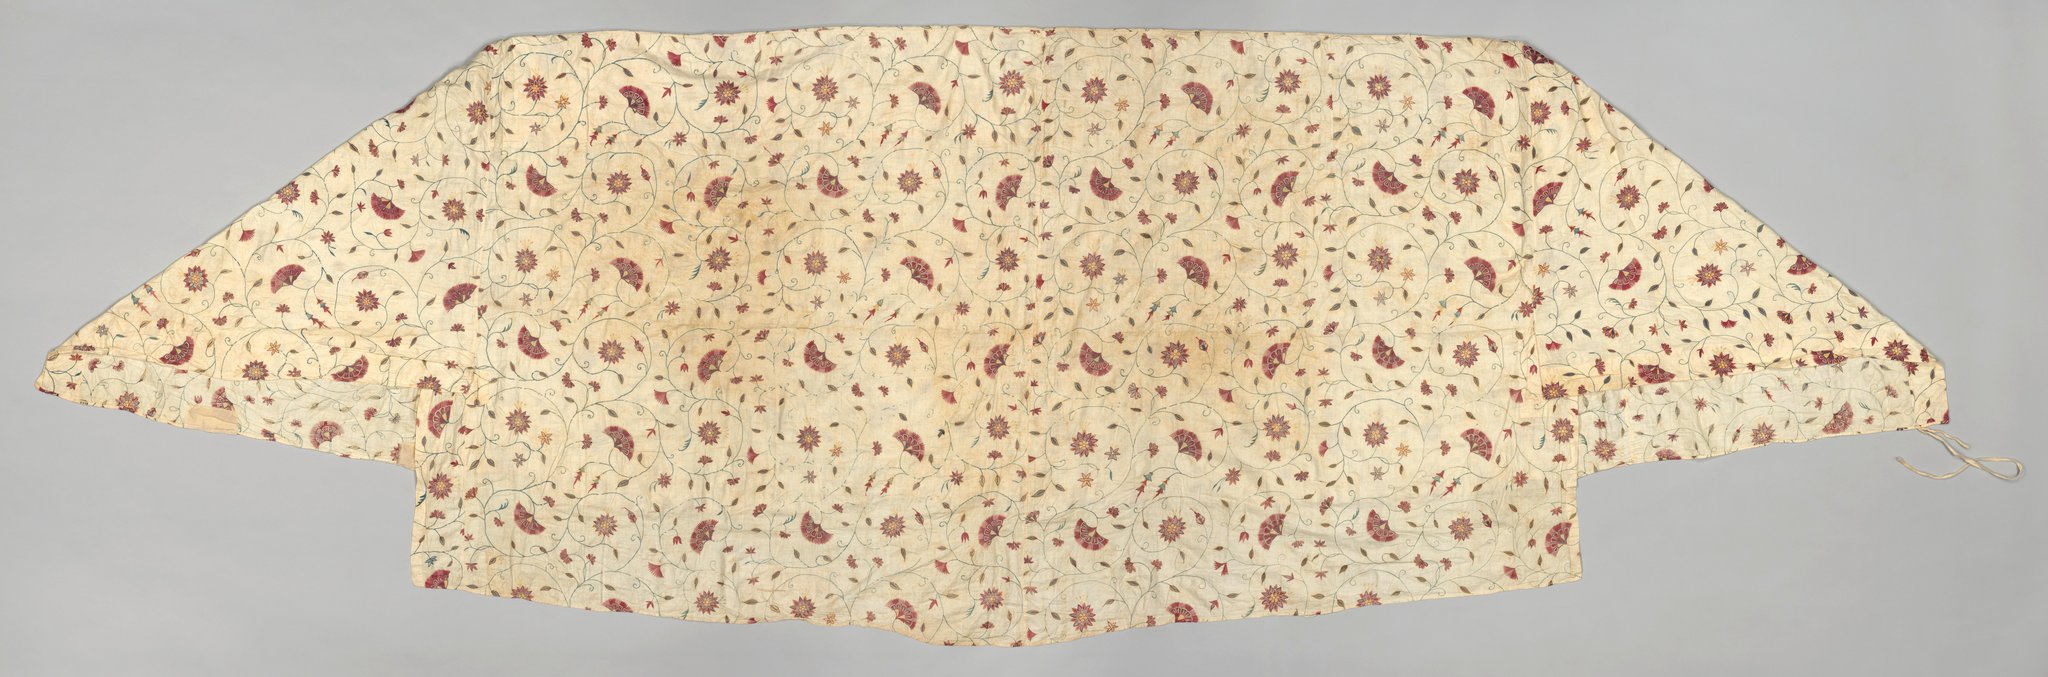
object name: tick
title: Overtrek van een meubelstuk, van geborduurde katoen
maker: Anonymous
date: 1700-1725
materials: cotton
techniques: embroidered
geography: iran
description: Overtrek van gekeperd wit katoen, met tamboereerwerk. Het patroon heeft fijne spiraalranken, in rechte rijen geplaatst met waaiervormige bloemen en rozetbloemen.